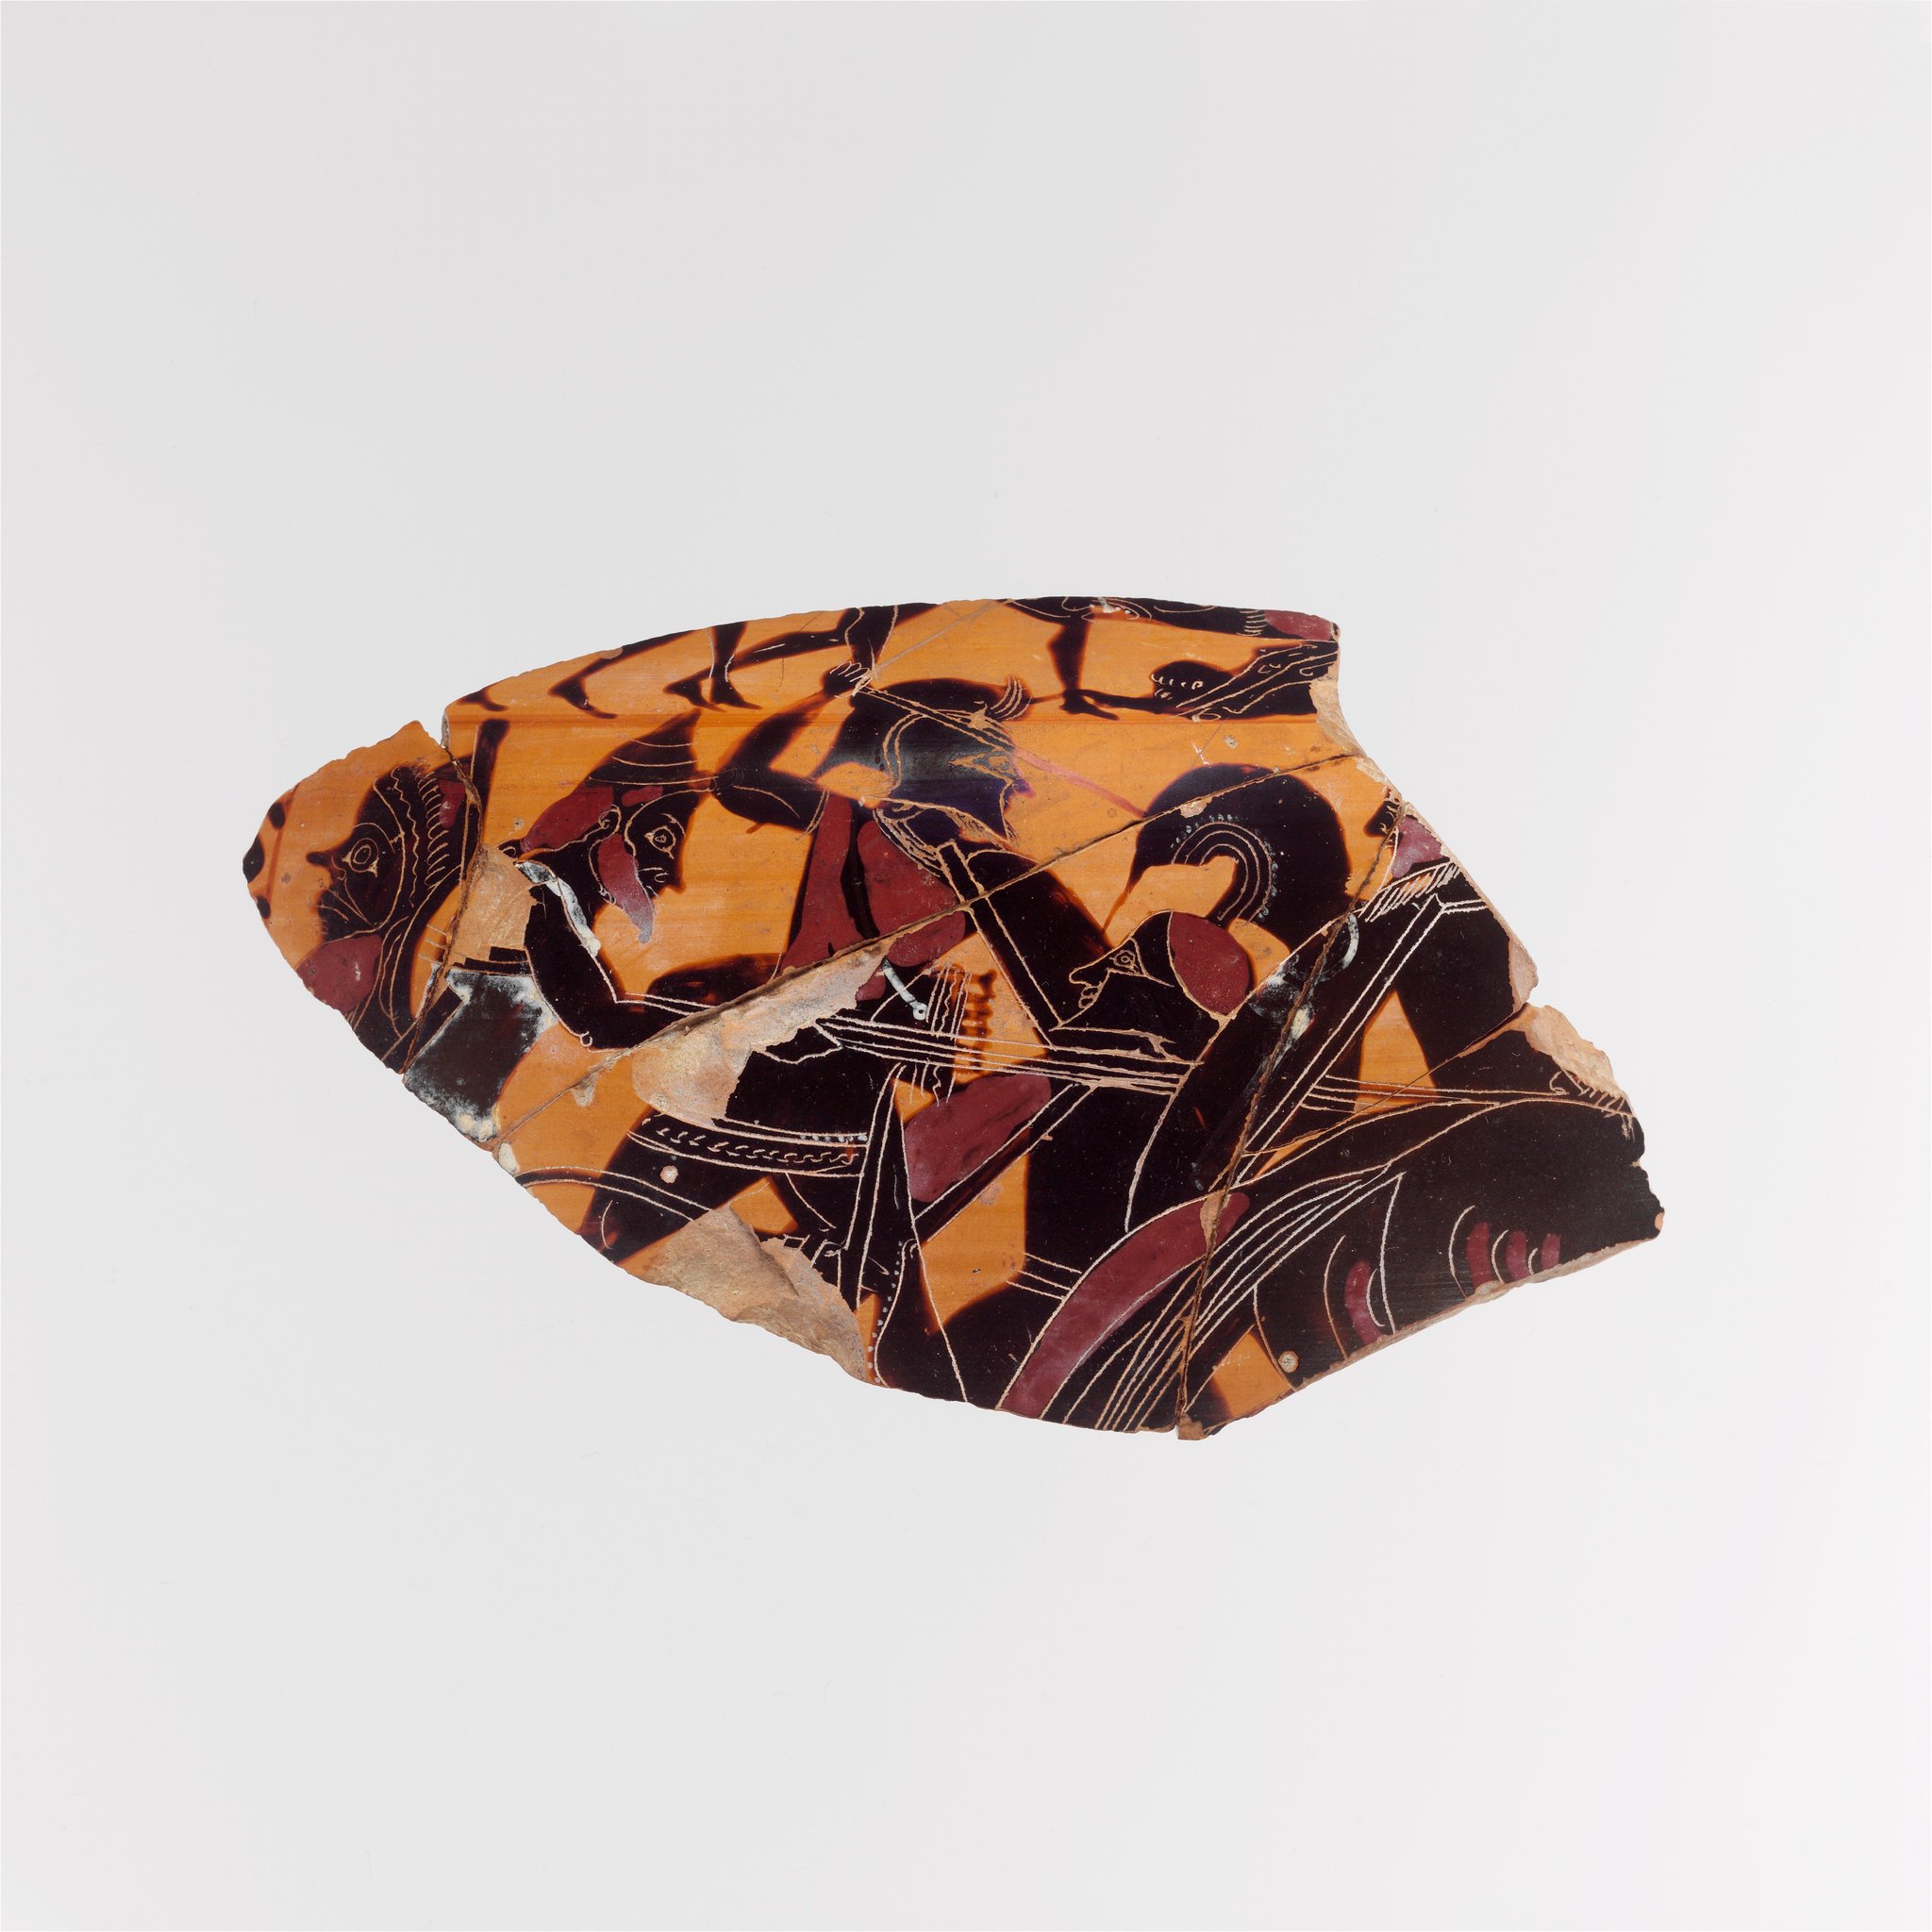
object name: hydria fragment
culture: greek, attic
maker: princeton painter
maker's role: artist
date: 540 BCE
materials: terracotta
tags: battles,men